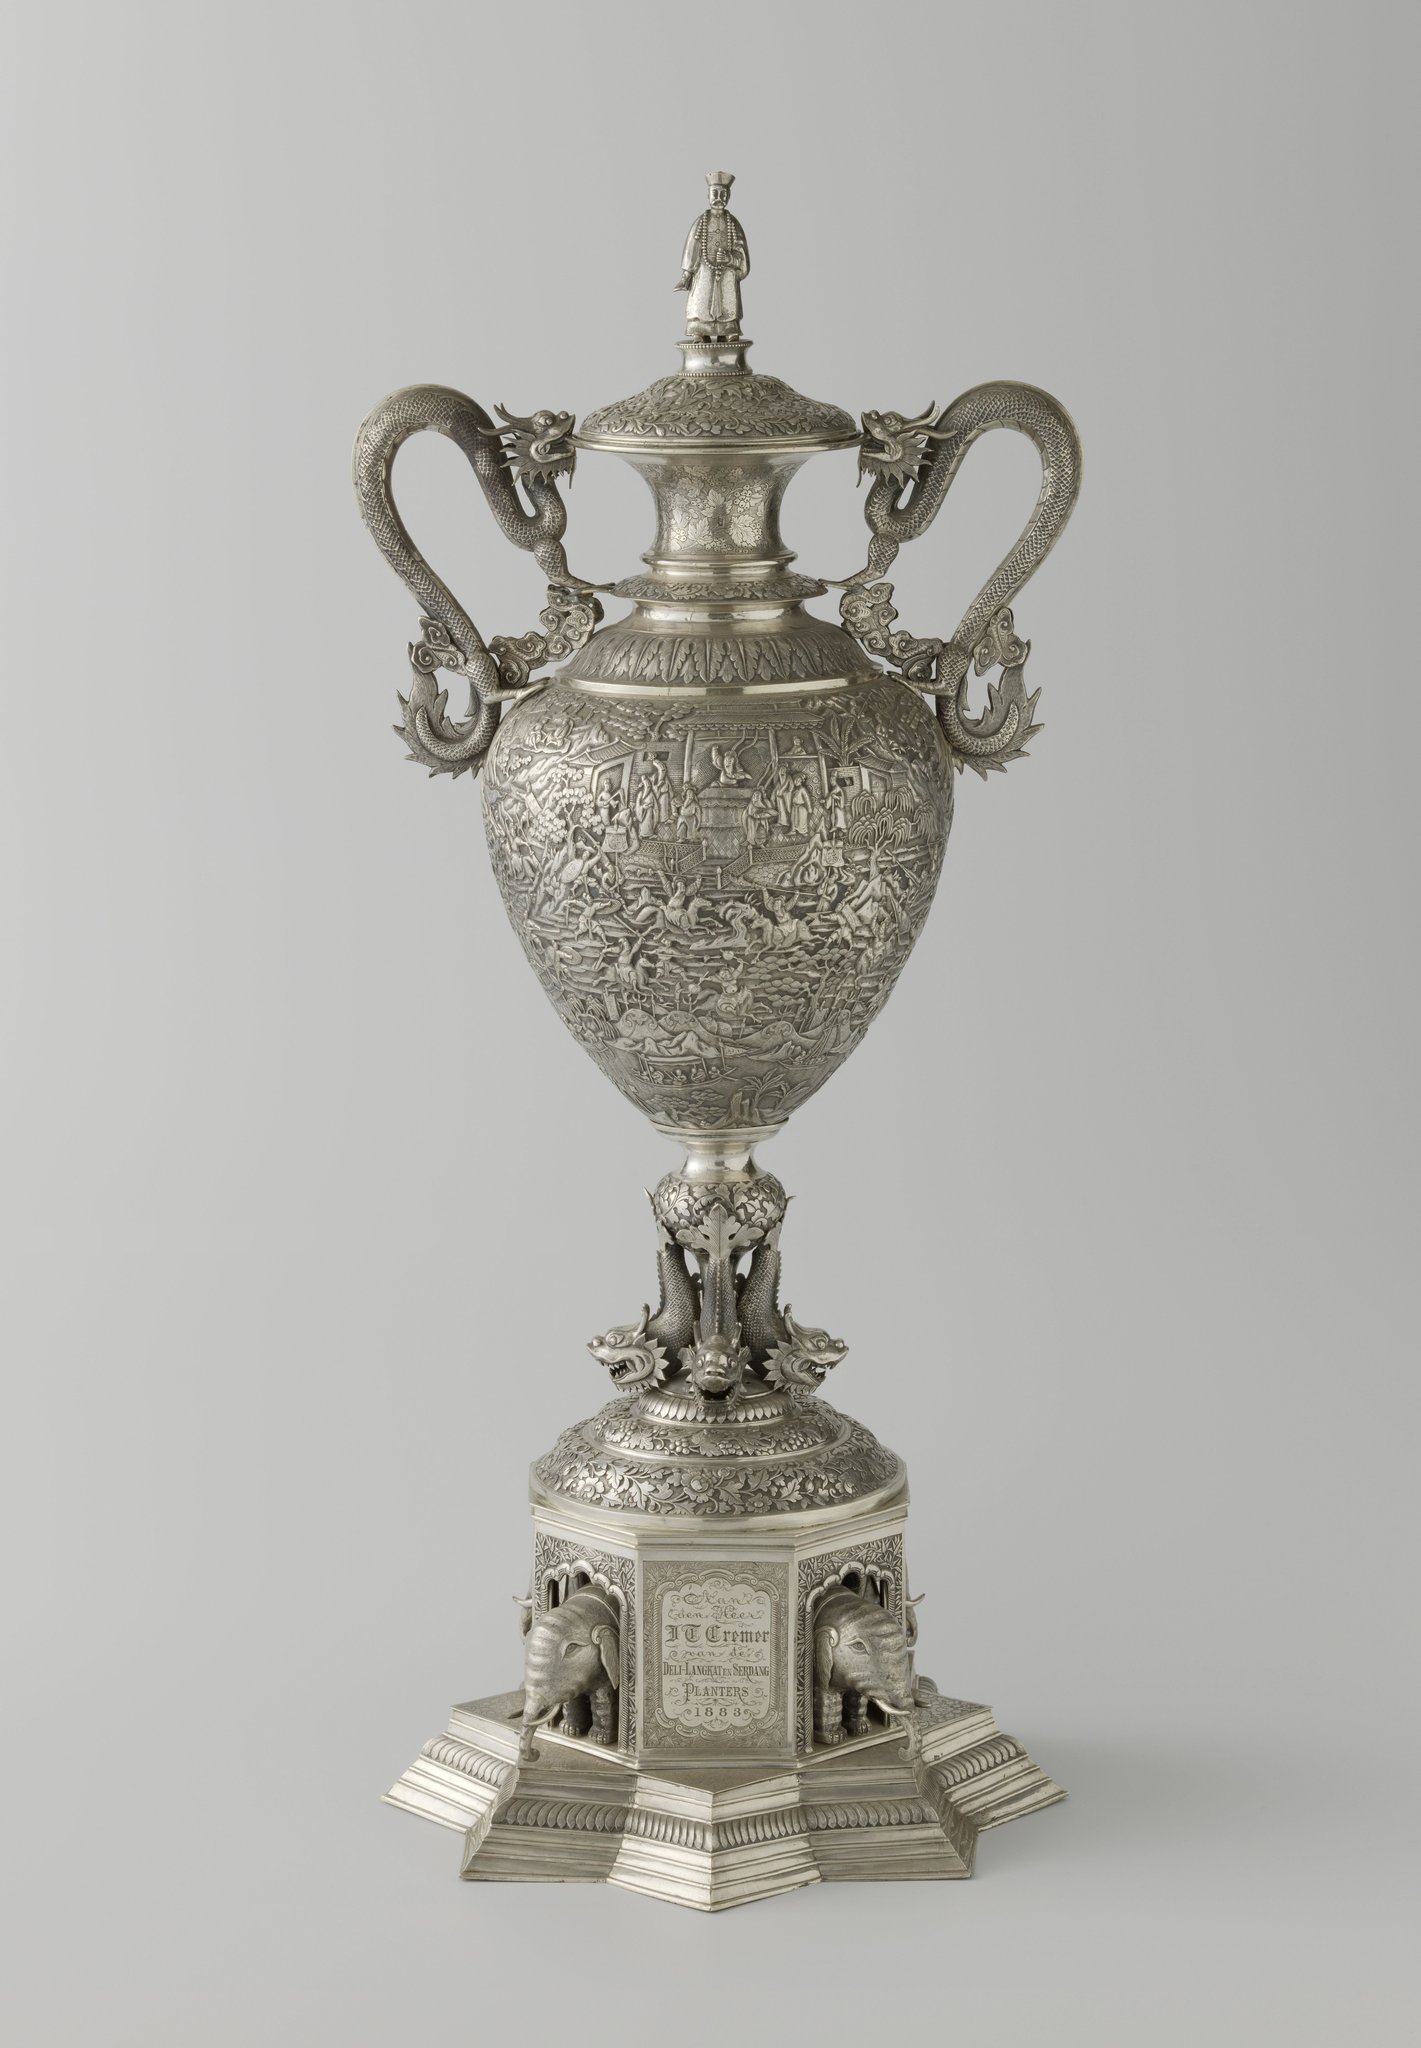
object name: table piece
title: Zilveren vaas op voetstuk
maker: Anonymous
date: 1880-1883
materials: silver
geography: china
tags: sumatra, china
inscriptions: mark, inscription: ‘Aan den Heer J.T. Cremer van de Deli-Langkat en Serdang planters 1883’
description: Jacob Theodoor Cremer was van 1870-1883 administrateur van de Deli-maatschappij. Hij droeg veel bij tot de opbloei van de tabakindustrie van Oost-Sumatra.